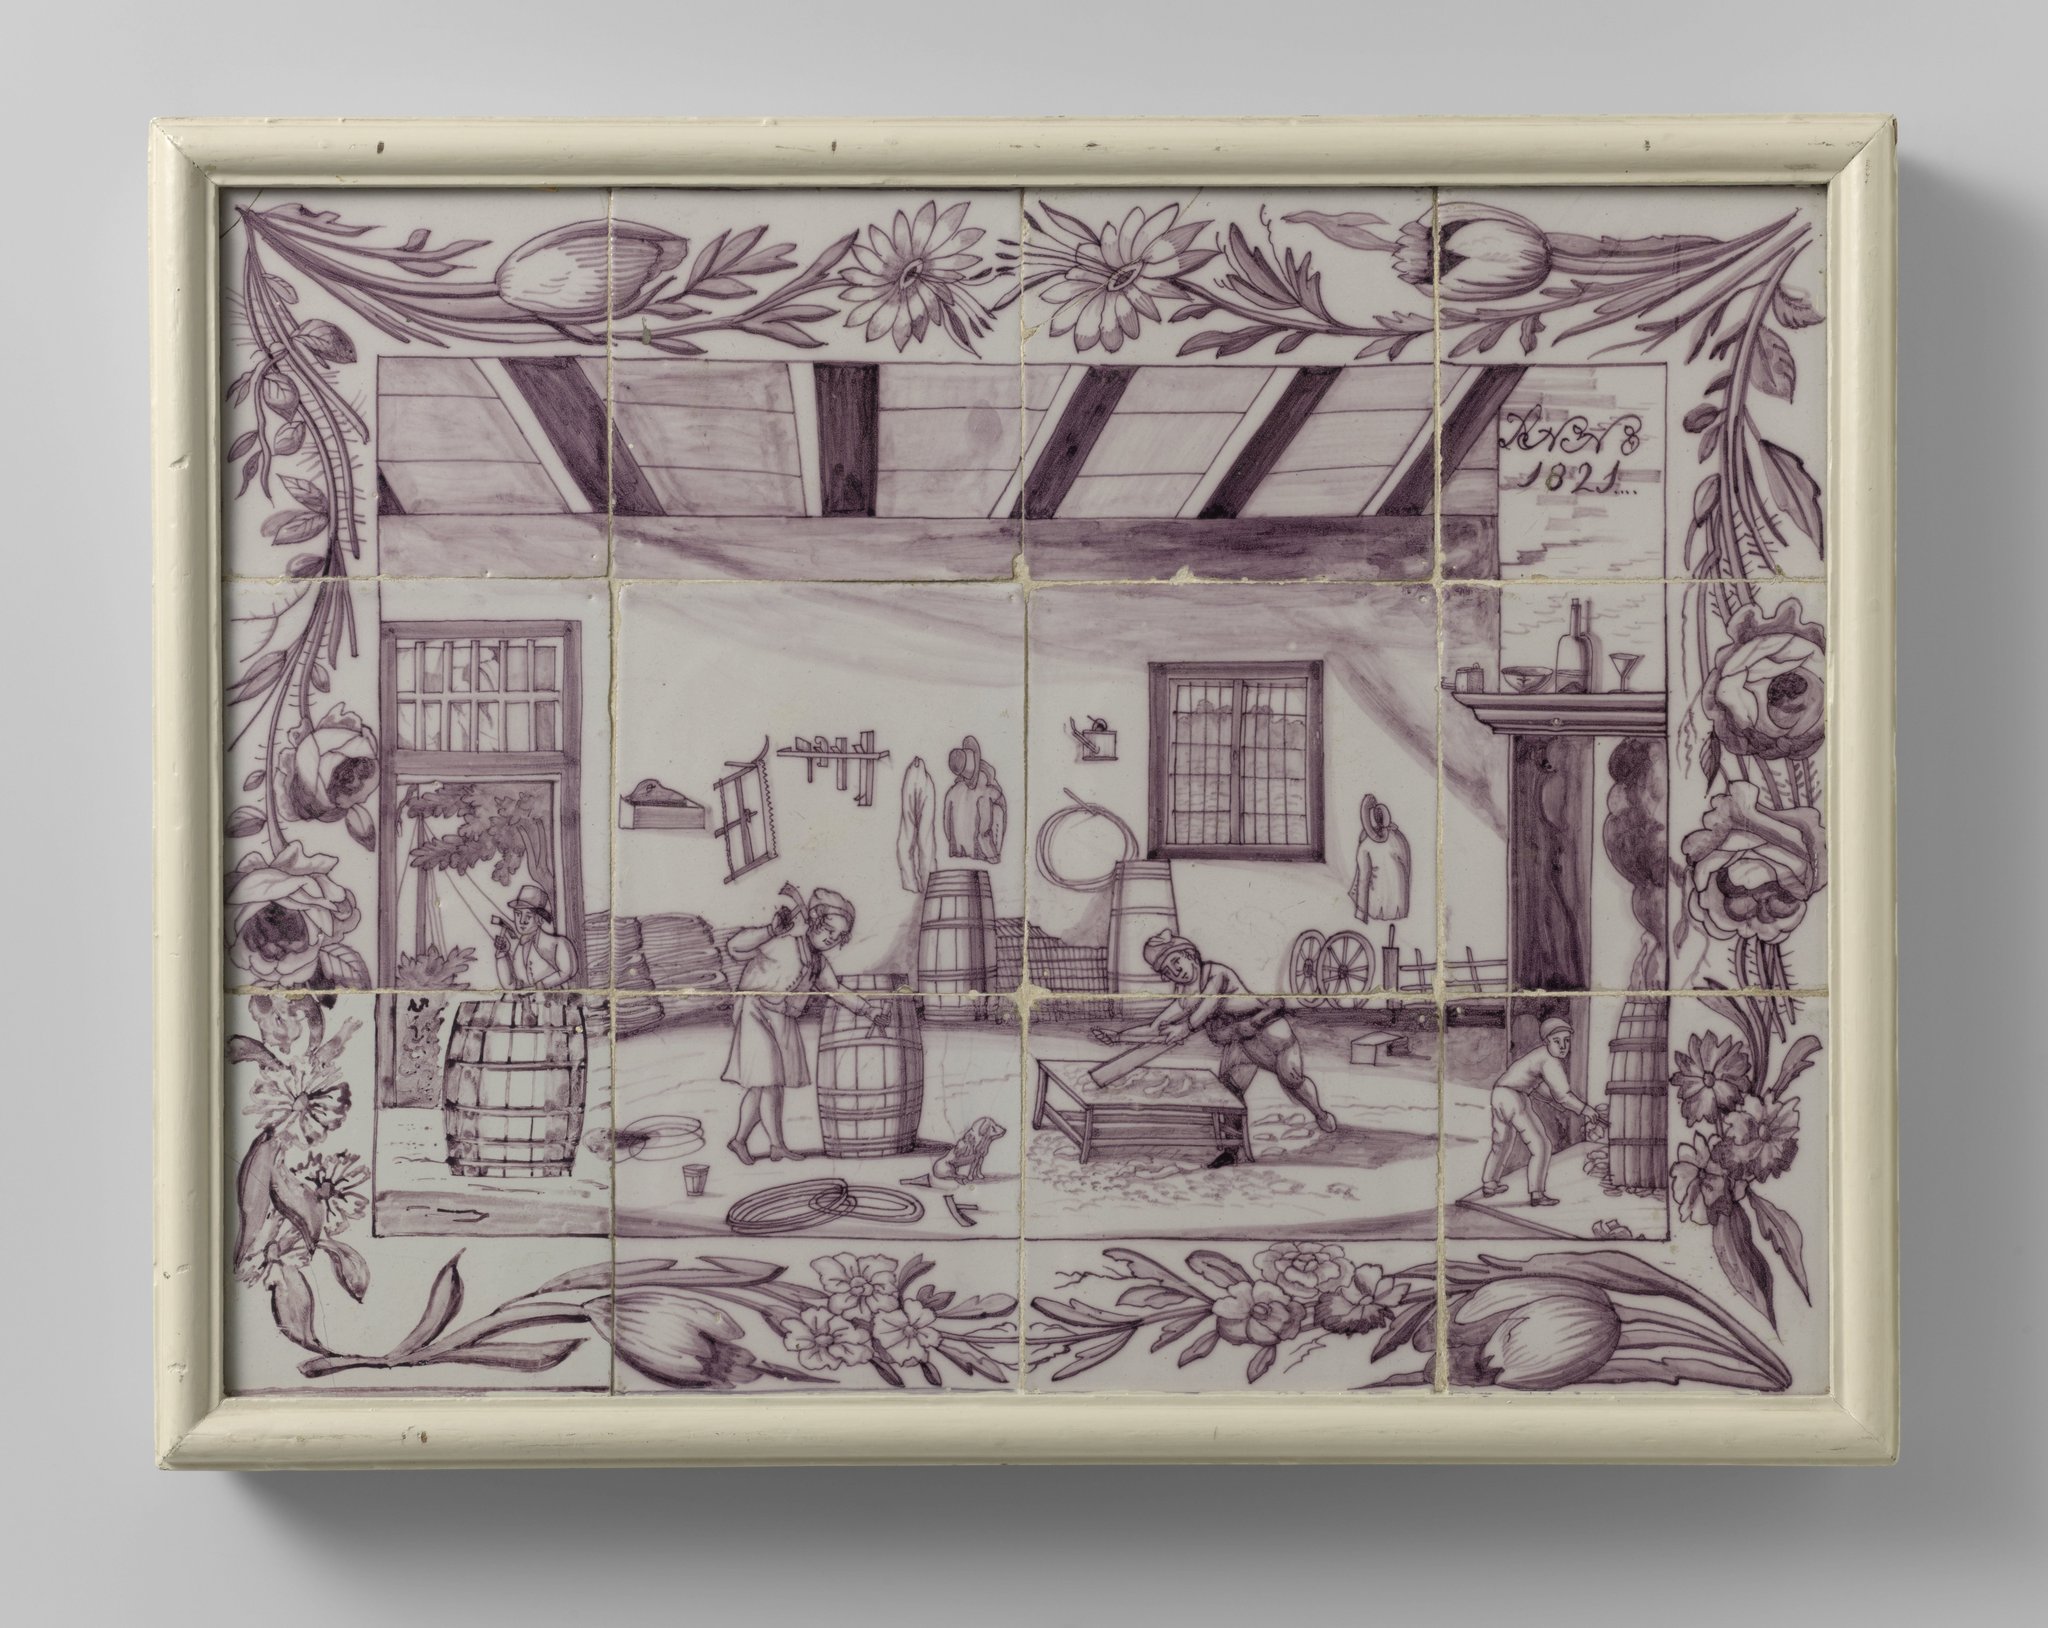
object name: tile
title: Tegeltableau van een kuiperij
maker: Anonymous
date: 1821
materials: earthenware, glaze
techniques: maiolica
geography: netherlands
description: Tegeltableau van twaalf tegels (3 x 4) met paars geschilderde figuren in een kuiperij. De omlijsting bestaat uit bloemen. Rechts boven het opschrift: ANNO 1821.